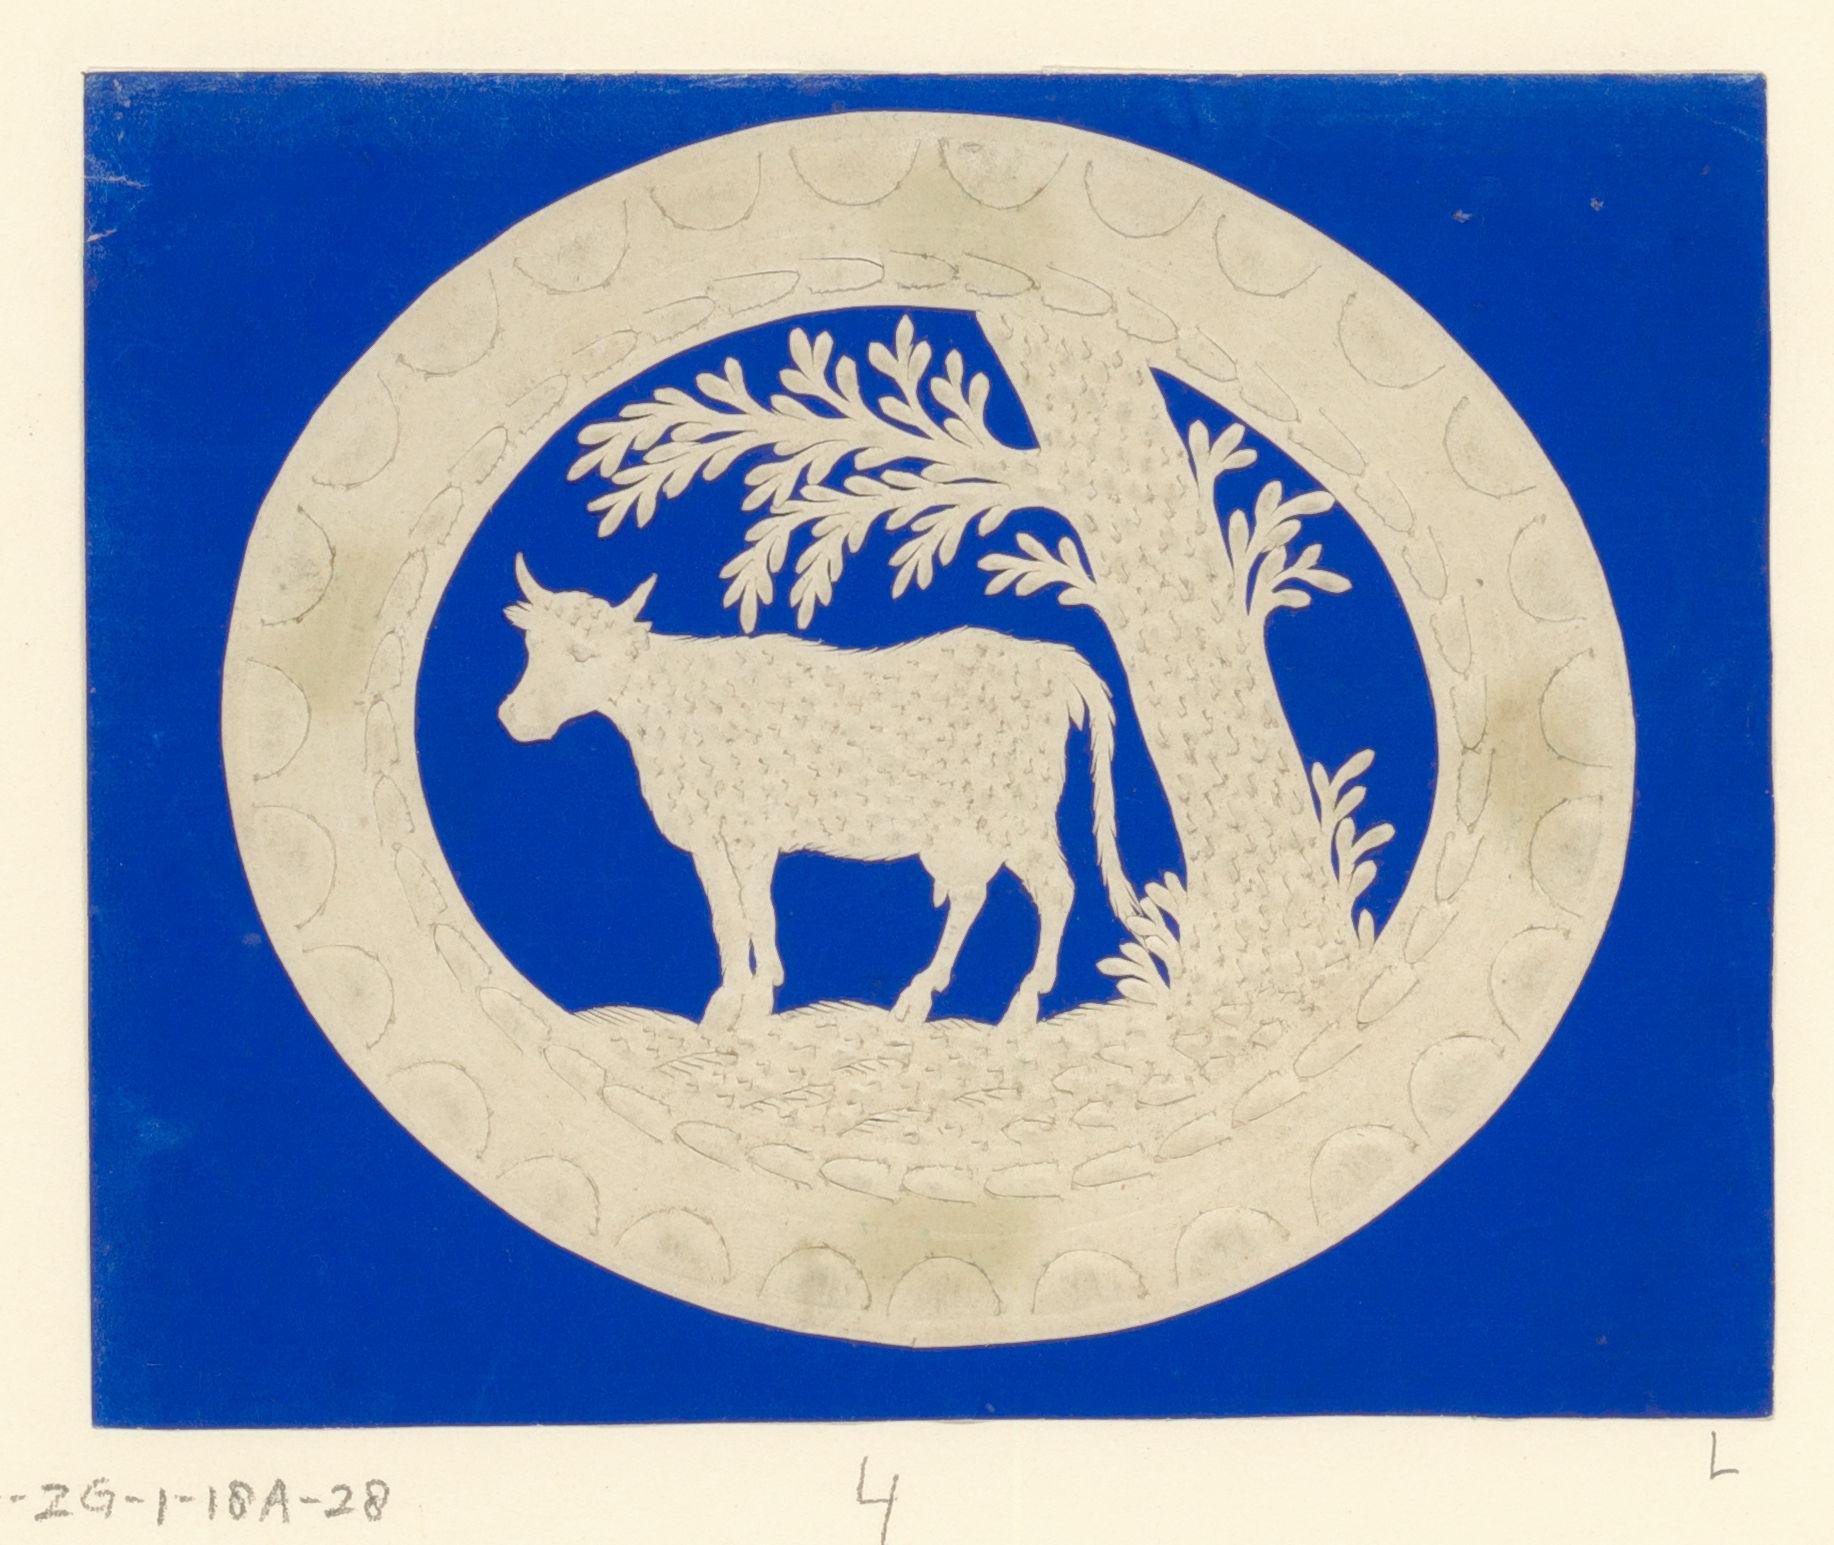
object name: cut paper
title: Koe bij een boom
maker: johannes sombeek slijper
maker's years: 1778-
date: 1788-1840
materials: paper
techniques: snipping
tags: trees, cow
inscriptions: collector's mark: Lugt 1641, stamp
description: Een staande koe met rechts een boom. Onderwerpsrubrieken binnen de Atlas Zeden en Gewoonten: Schoone kunsten, Knipkunst.